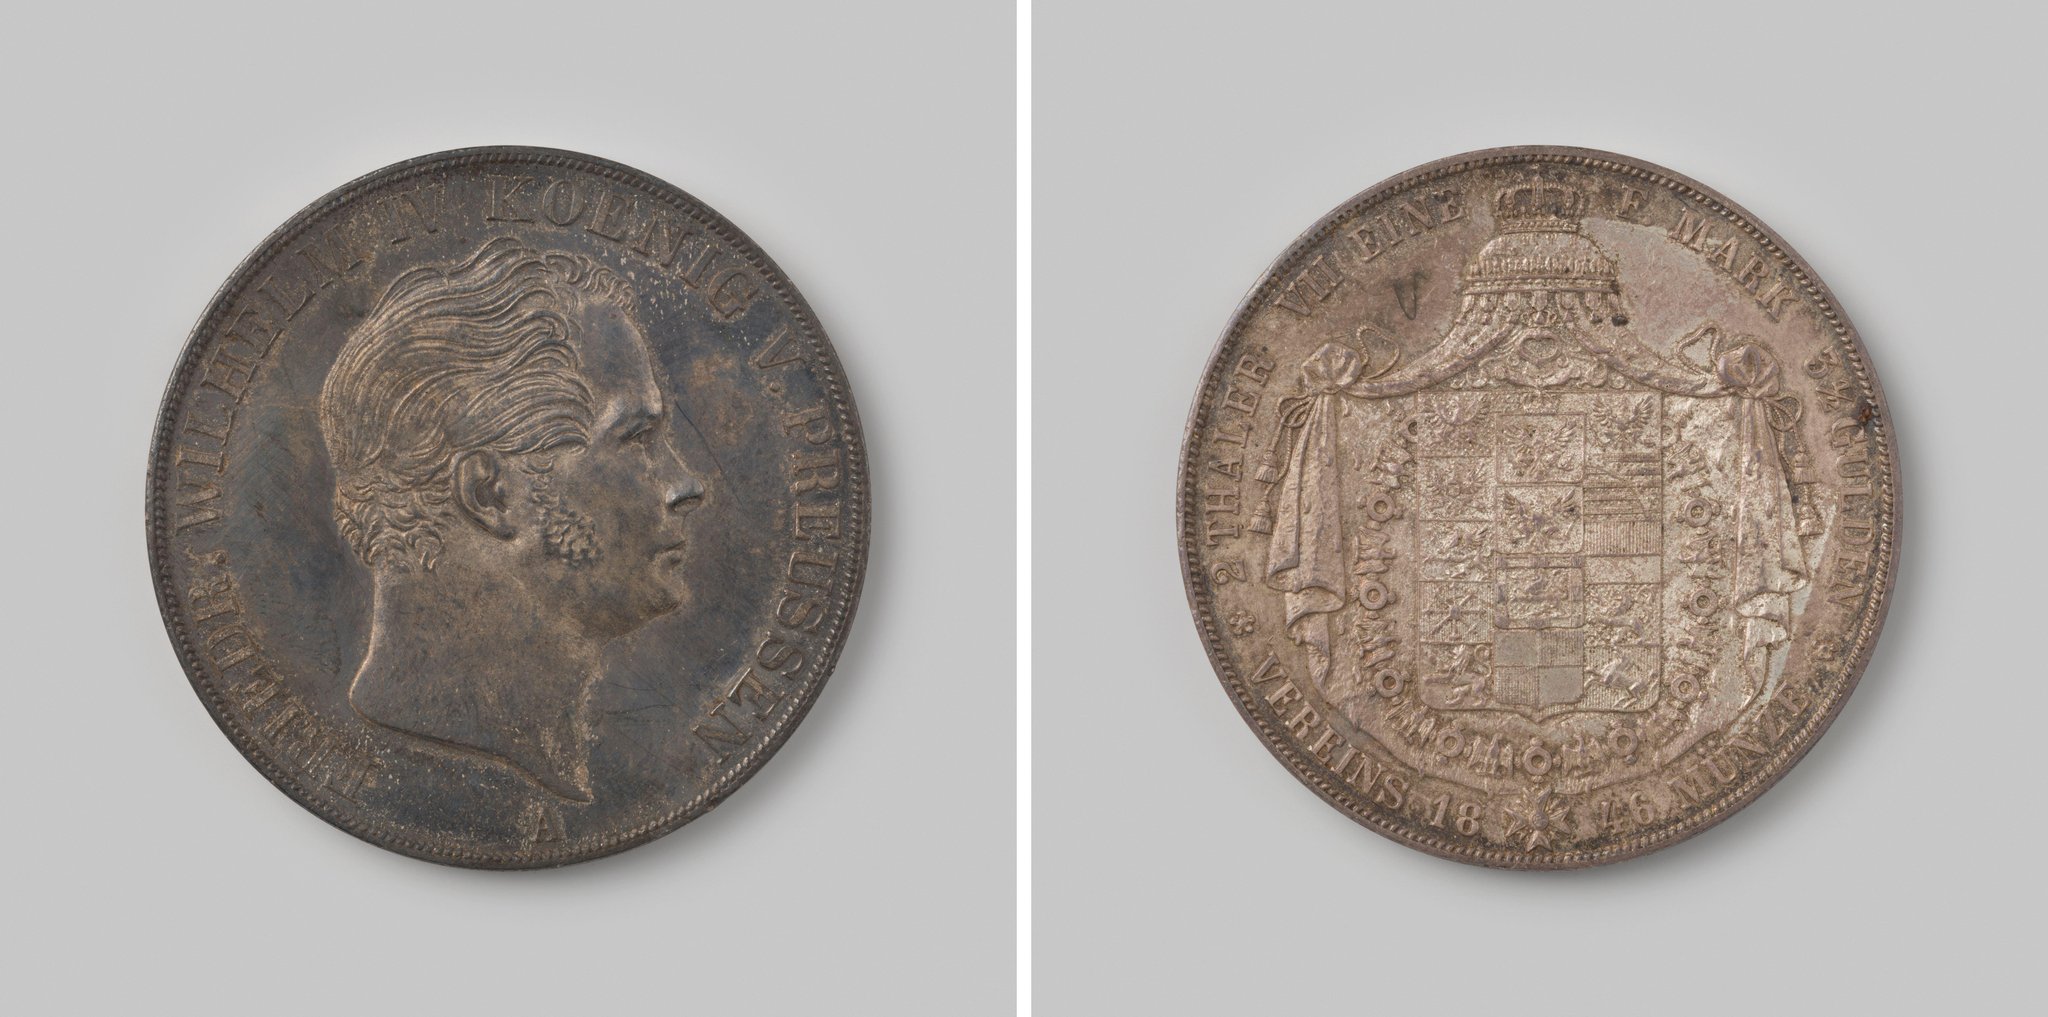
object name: dubbele taler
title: Dubbele taler uit Pruisen van Friedrich Wilhelm IV, 1846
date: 1846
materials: silver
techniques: striking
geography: berlin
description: Zilveren munt. Voorzijde: hoofd van de koning naar rechts. Daaronder letter A. Keerzijde: onder een gekroonde wapenmantel een door de keten en het juweel van een ridderorde omhangen samengesteld wapenschild. Links in omschrift waarde-aanduiding: 2 Thaler, rechts: 3½ Gulden en jaartal onderaan. Randschrift.